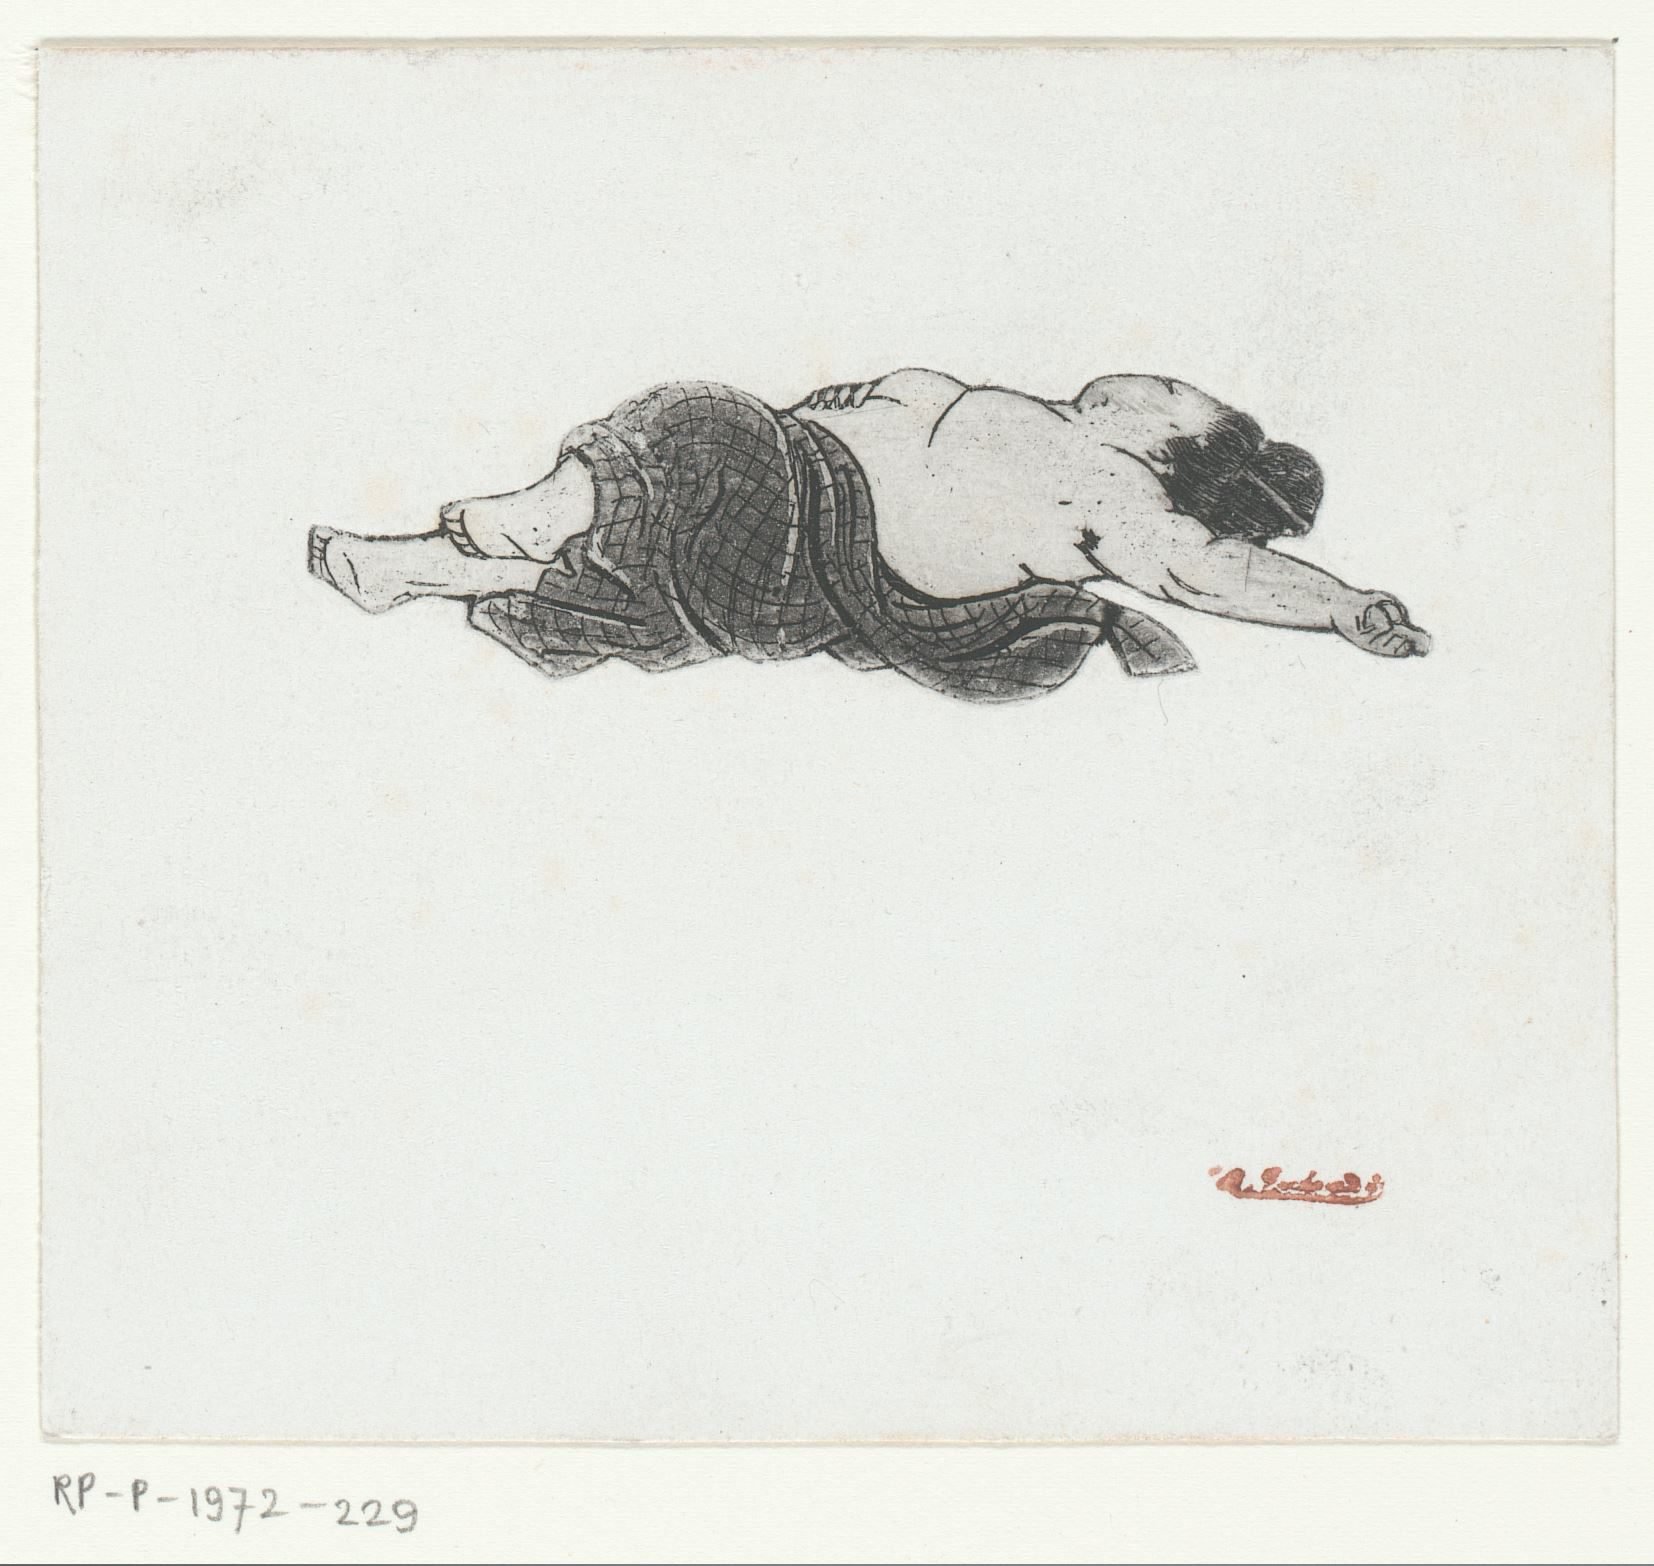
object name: print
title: Liggende Japanse vrouw met ontbloot bovenlijf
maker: henri charles guérard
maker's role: print maker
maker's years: 1846-1897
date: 1856-1897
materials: paper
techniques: etching, intaglio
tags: woman (showing herself) undressed, quasi-nude, lying figure - aa - female human figure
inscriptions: collector's mark: Lugt 2228, collector's mark: Lugt 2760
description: Dit betreft een plaat, geknipt uit RP-P-1972-228.